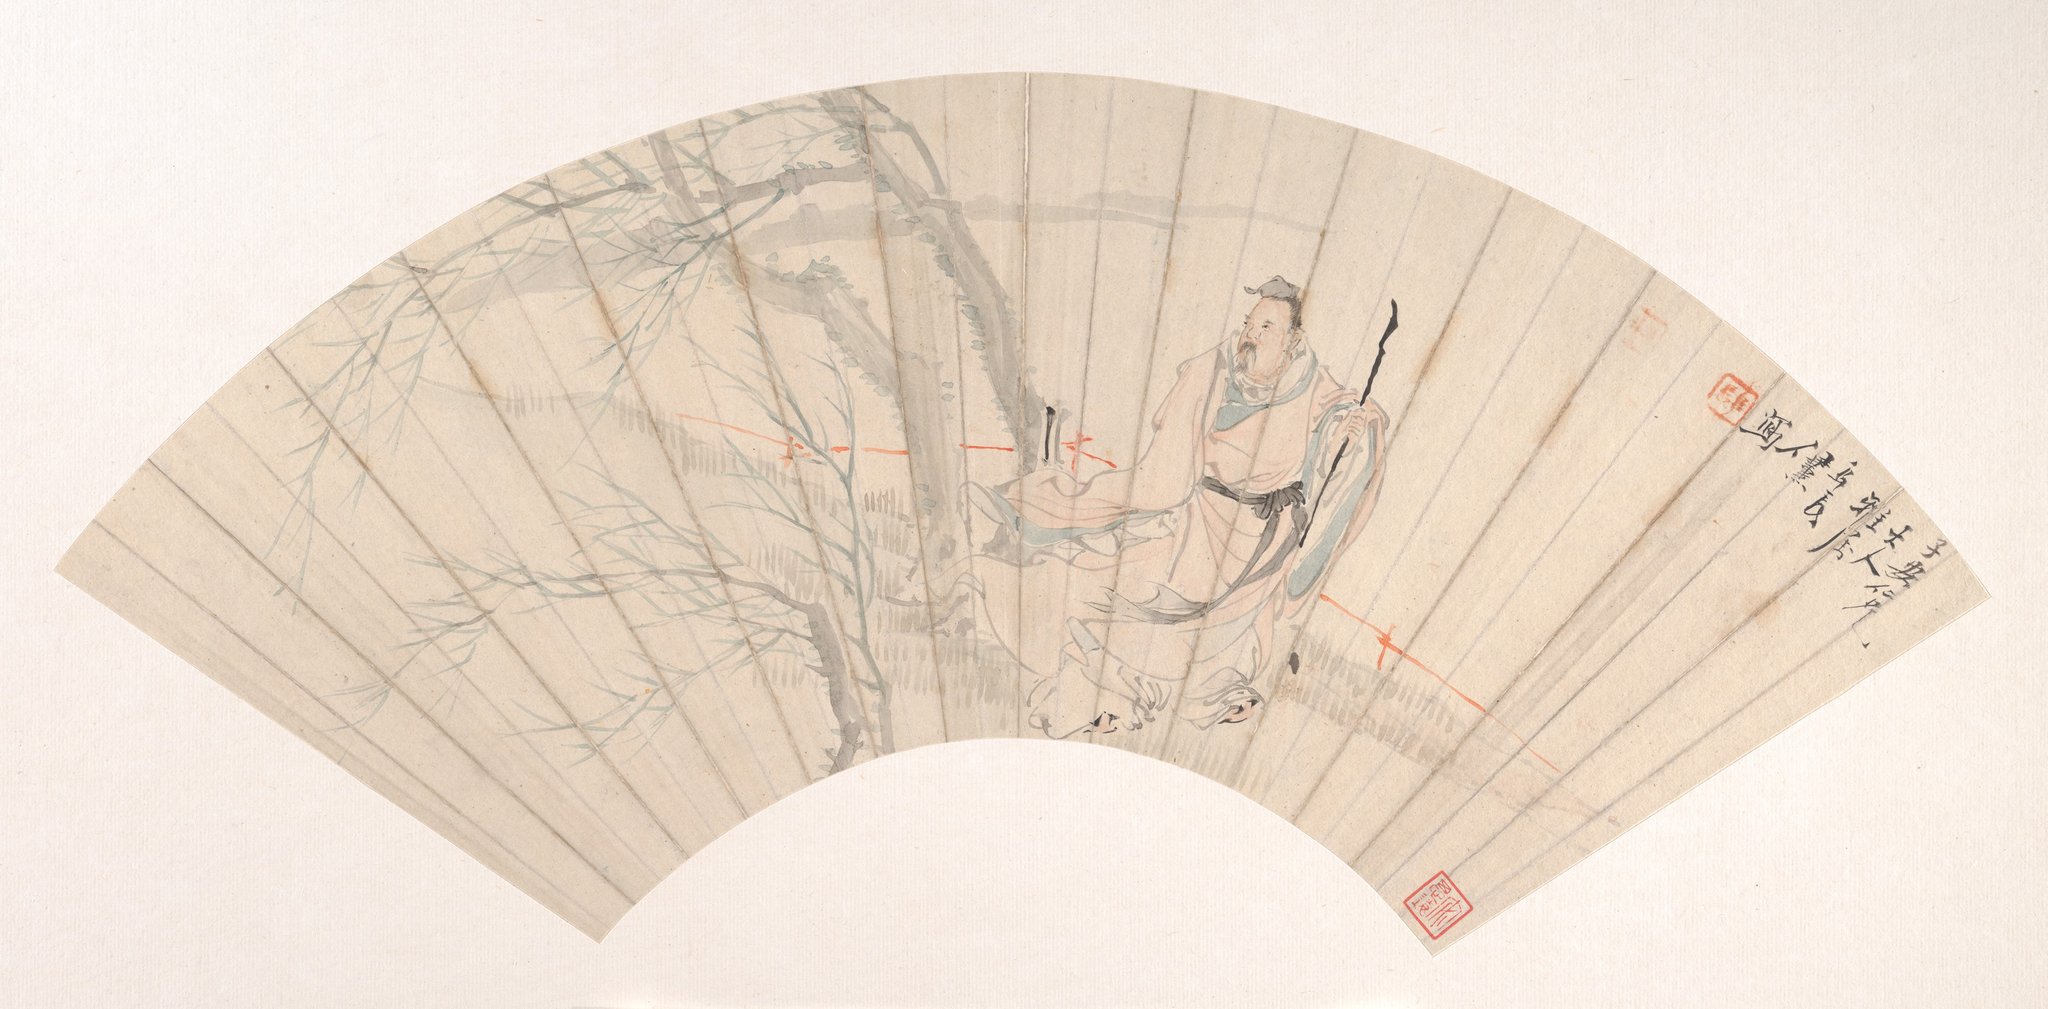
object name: folding fan mounted a an album leaf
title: Scholar in the Wind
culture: chinese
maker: ren xun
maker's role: artist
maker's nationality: chinese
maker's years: 1835-1893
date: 1880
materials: ink, paper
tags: men